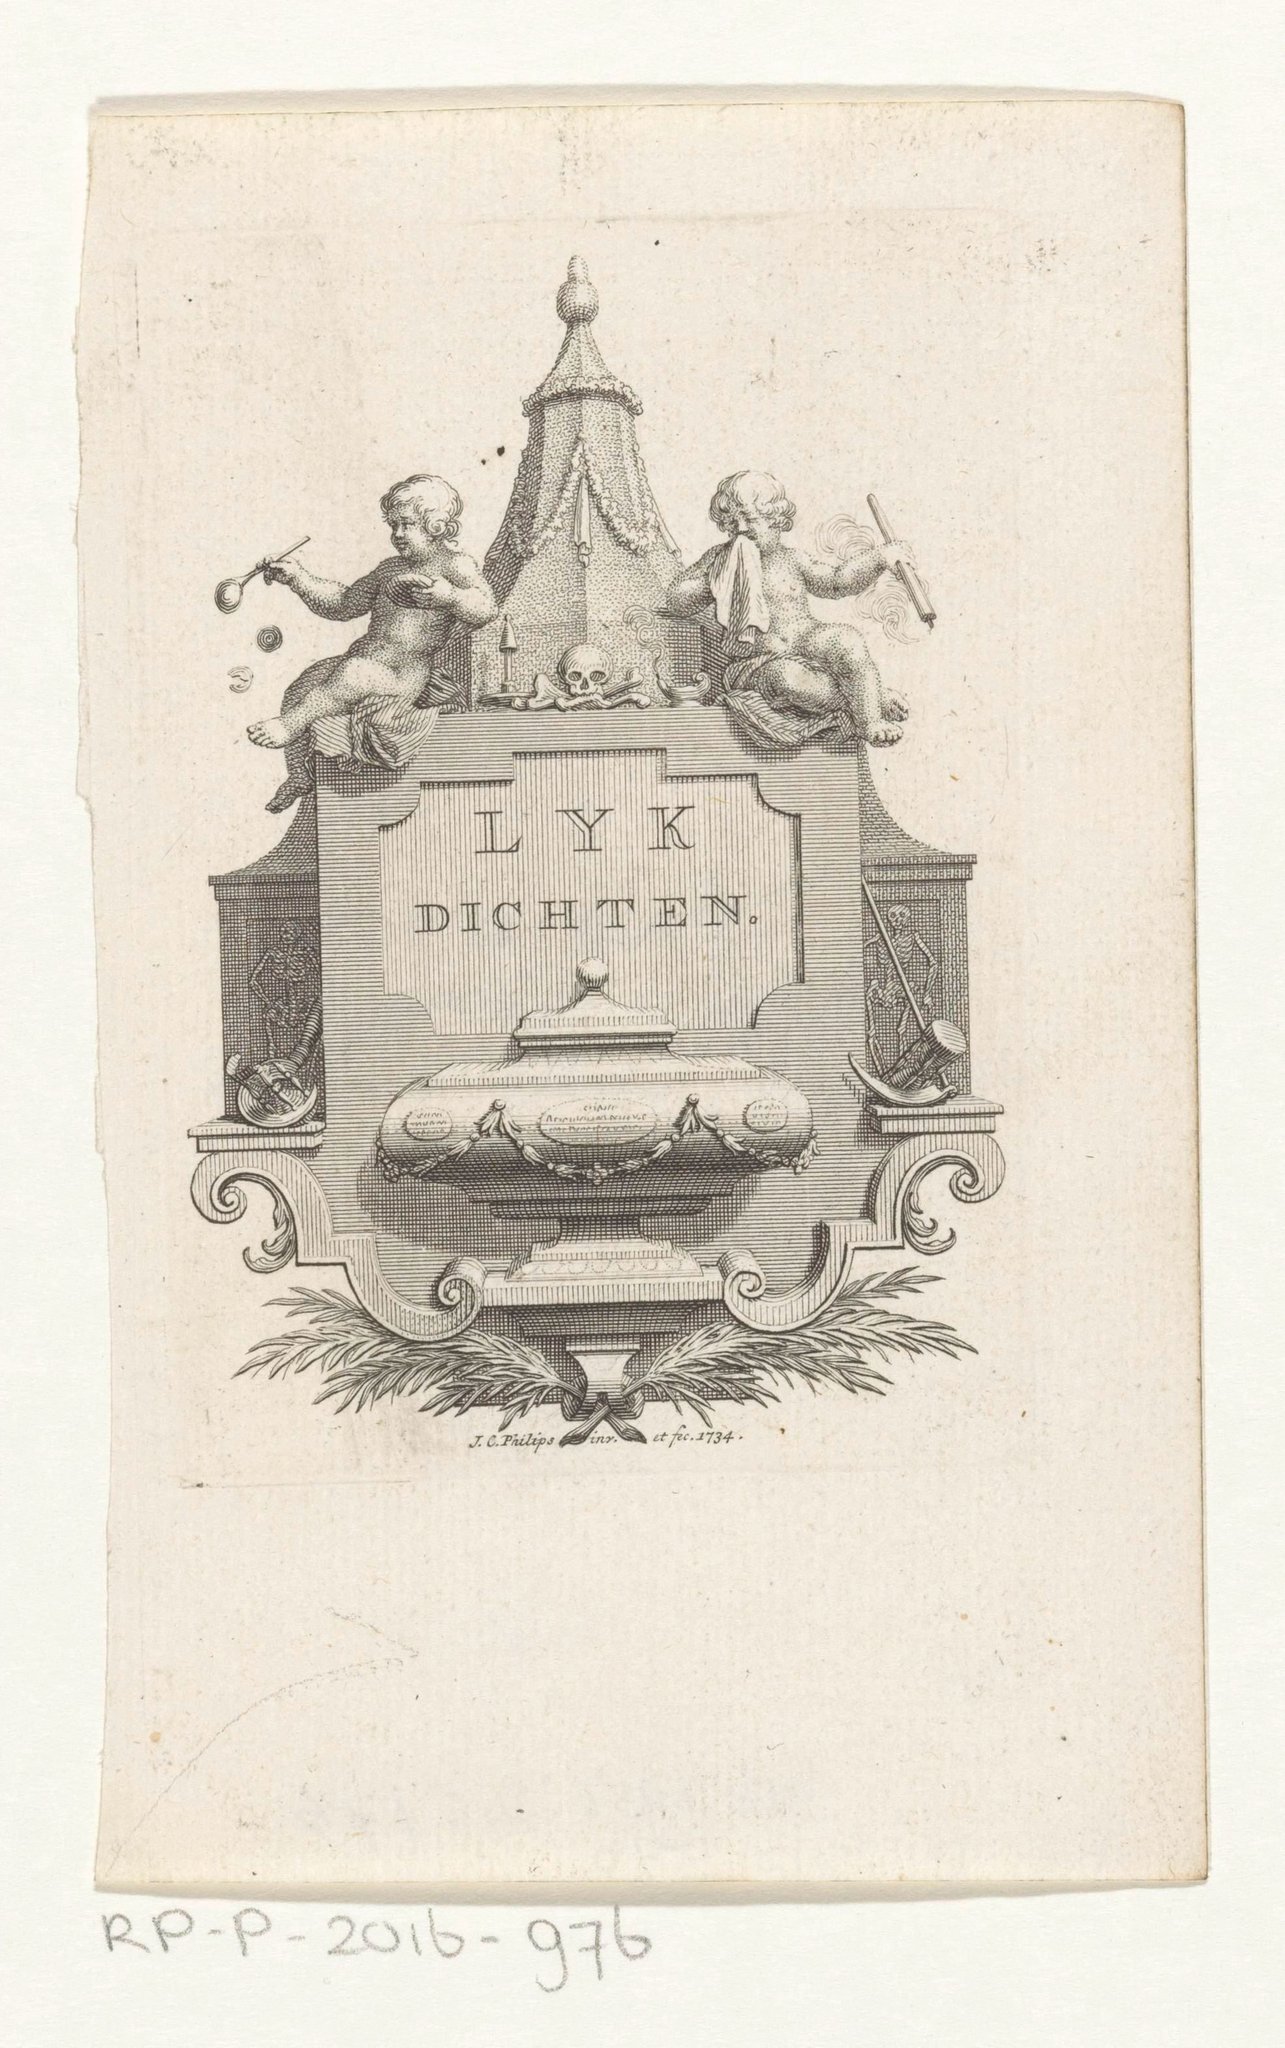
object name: print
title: Lyk dichten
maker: jan caspar philips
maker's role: draughtsman, print maker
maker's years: 1700-1775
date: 1734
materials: paper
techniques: engraving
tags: torch - bb - torch held upside down, grave, tomb and other grave-forms and grave-markers, cupids: 'amores', 'amoretti', 'putti', (children or putti) blowing bubbles, 'homo bulla' ~ scene symbolizing 'vanitas'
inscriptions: collector's mark: Lugt 2228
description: Mogelijk een boekillustratie of titelpagina uit een gedichtenbundel. Prent afkomstig uit een plakalbum met titelprenten, ornamenten etc. op blauw papier in 1983 uit elkaar gehaald. Volgens een notitie op verso zat de prent op p. 76 van dit album.